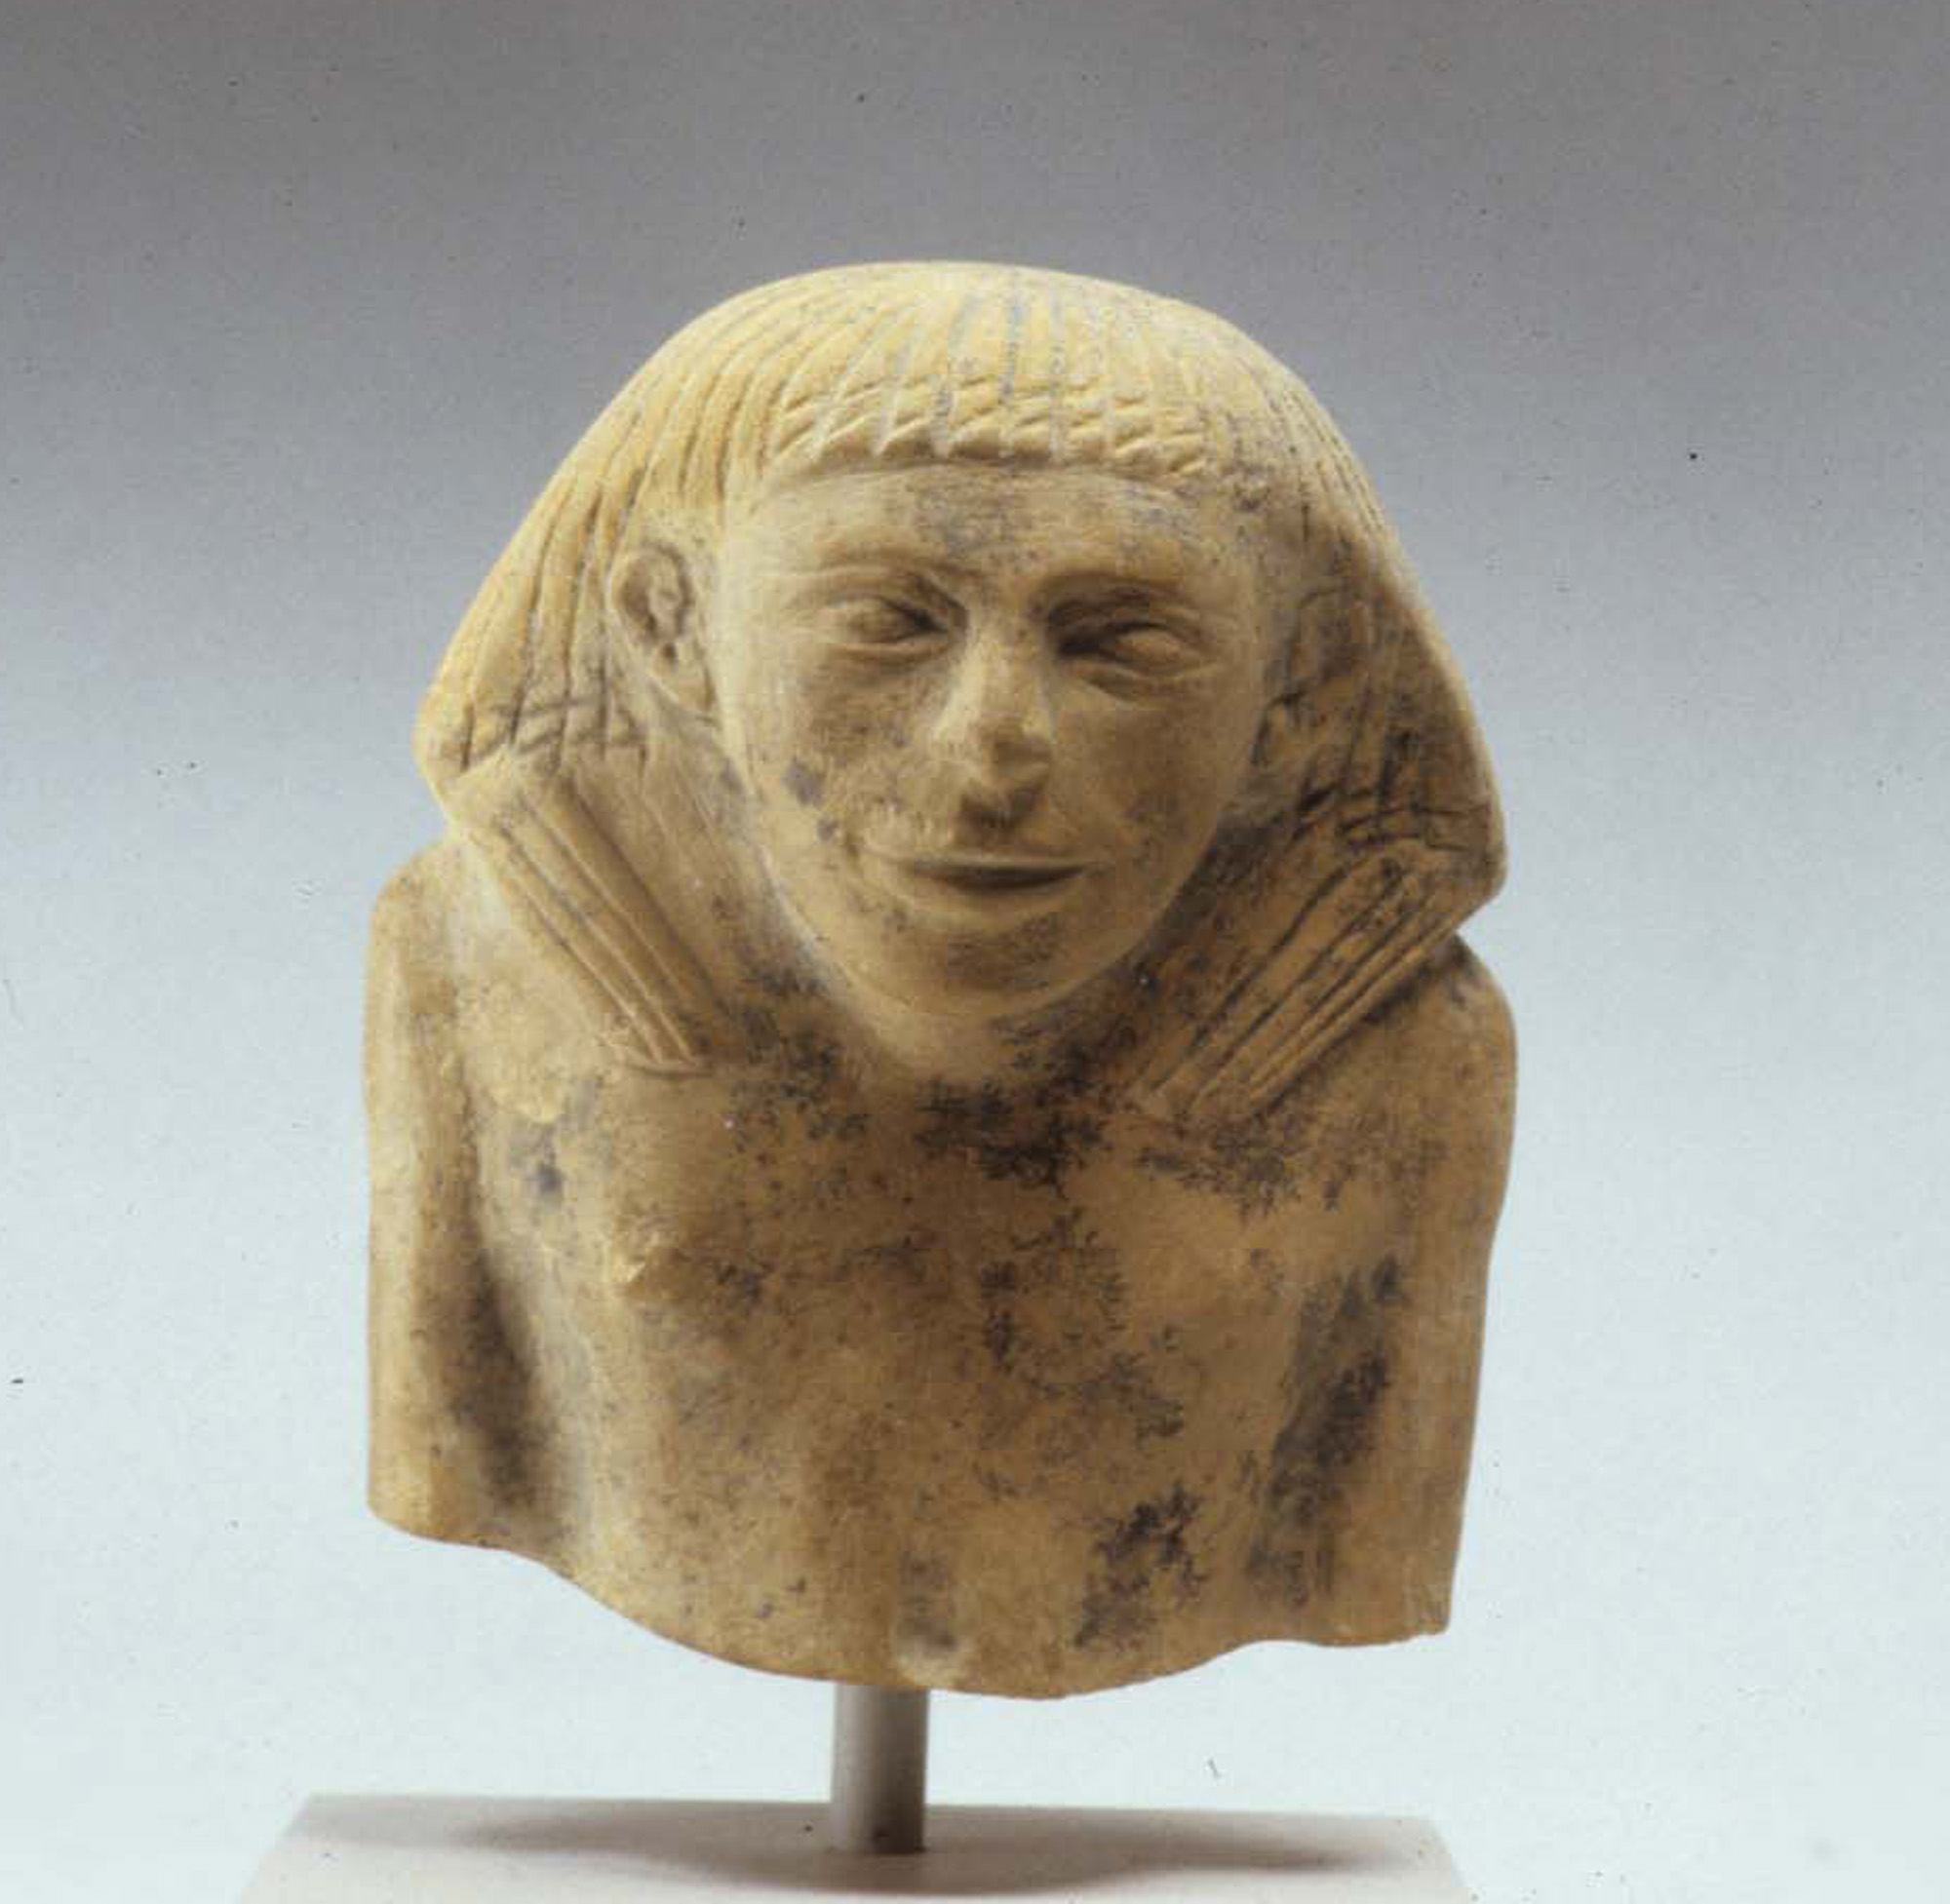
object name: bust, male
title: Upper part of male statue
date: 1850-1640 BCE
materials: limestone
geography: egypt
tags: men